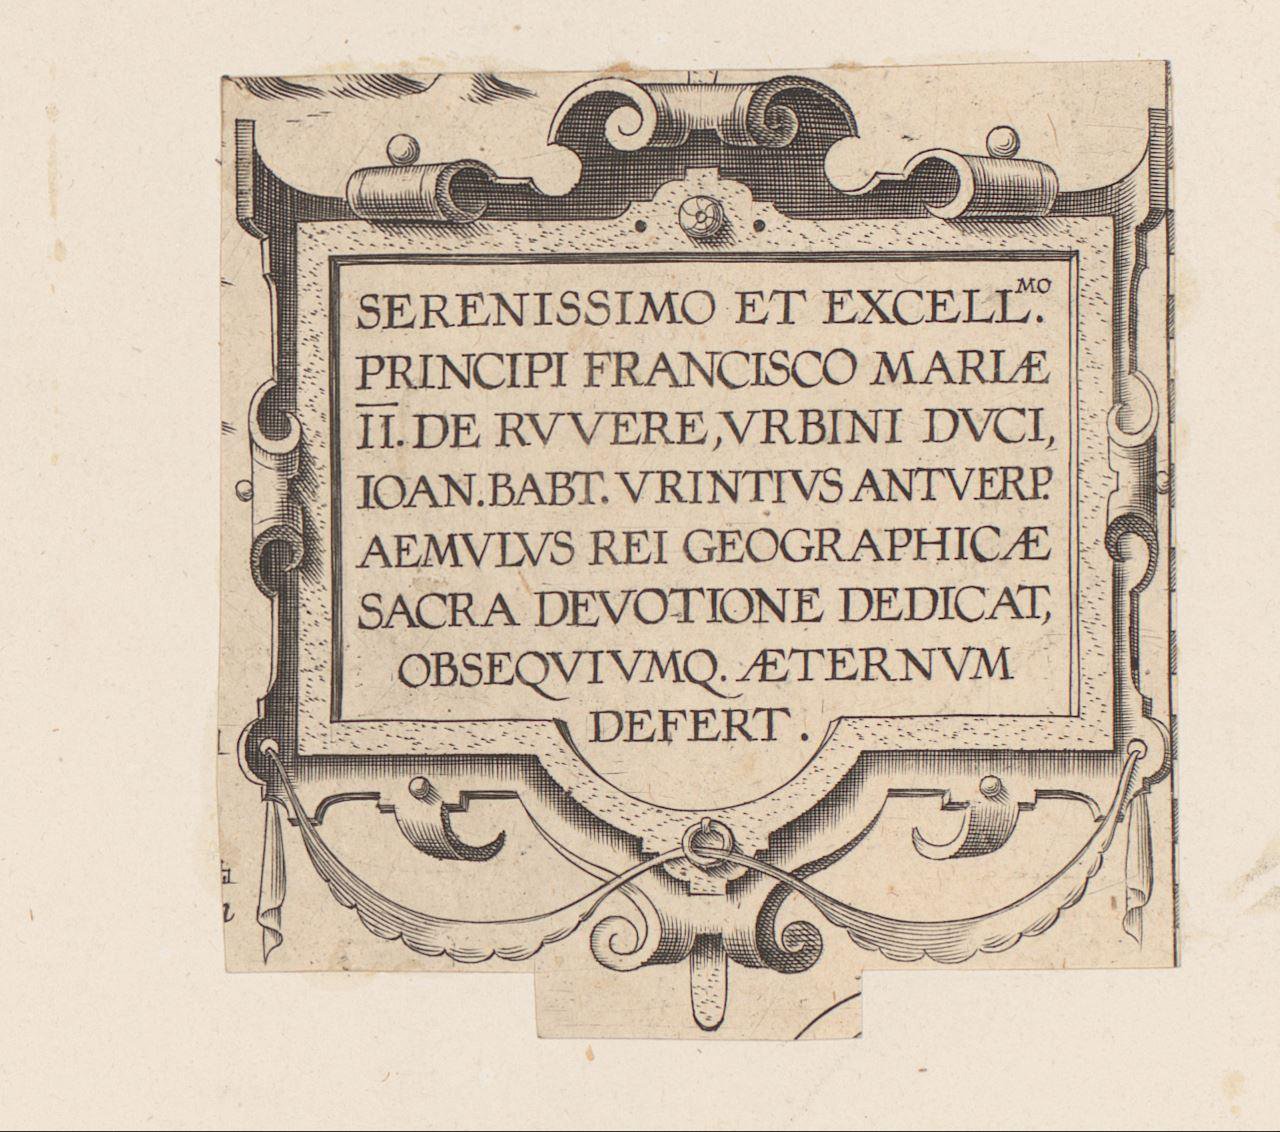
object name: album leaf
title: Rechthoekige cartouche met slinger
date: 1606-1608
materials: paper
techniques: engraving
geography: antwerp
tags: scrollwork, strapwork ~ ornament, ornament ~ cartouche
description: Rechthoekige cartouche met slinger. Met achtregelige dedicatietekst: Serenissimo et excell.mo ... Oorspronkelijk daarboven het wapen van Francesco Maria II Della Rovere. De cartouche is een fragment van een kaart van het hertogdom Urbino. De prent maakt deel uit van een album.